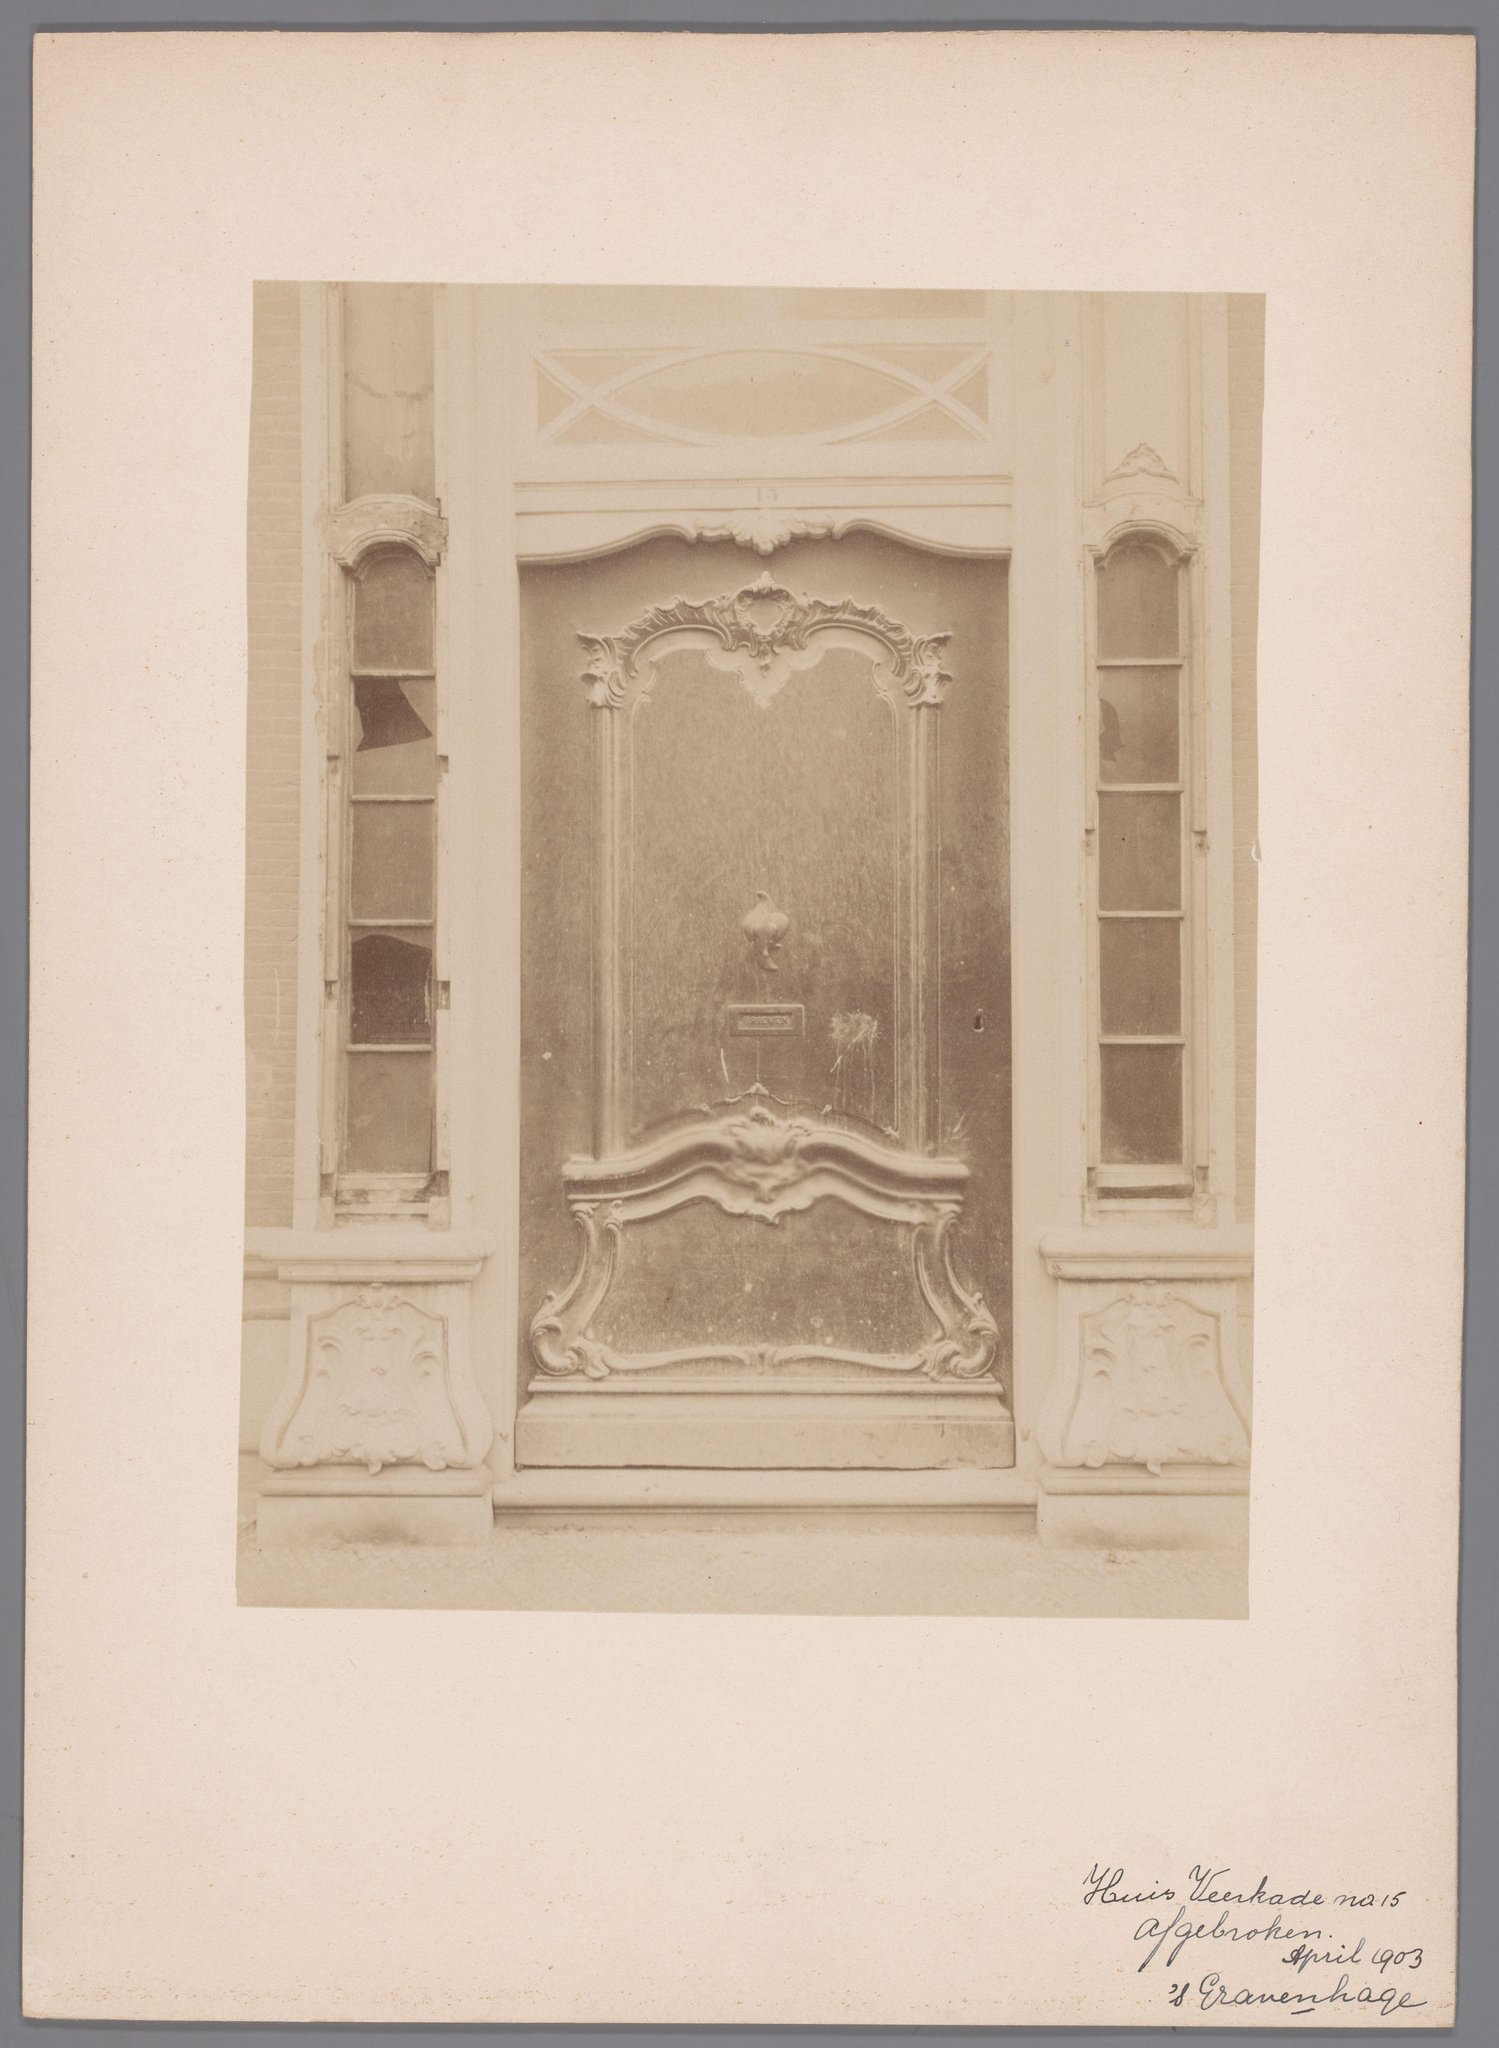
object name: photograph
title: Deur van Veerkade 15 te Den Haag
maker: anoniem (monumentenzorg)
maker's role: fotograaf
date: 1903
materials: cardboard, photographic support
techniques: albumen print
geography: the hague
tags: door, the hague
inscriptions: annotation: ‘'s Gravenhage (Z.H.)/ huis Veerkade 15/ afgebroken & geph./ april 1903’, annotation: ‘Huis Veerkade no. 15/ April 1903/ 's Gravenhage’, collector's mark: ‘R:MUS.’ Lugt 2228